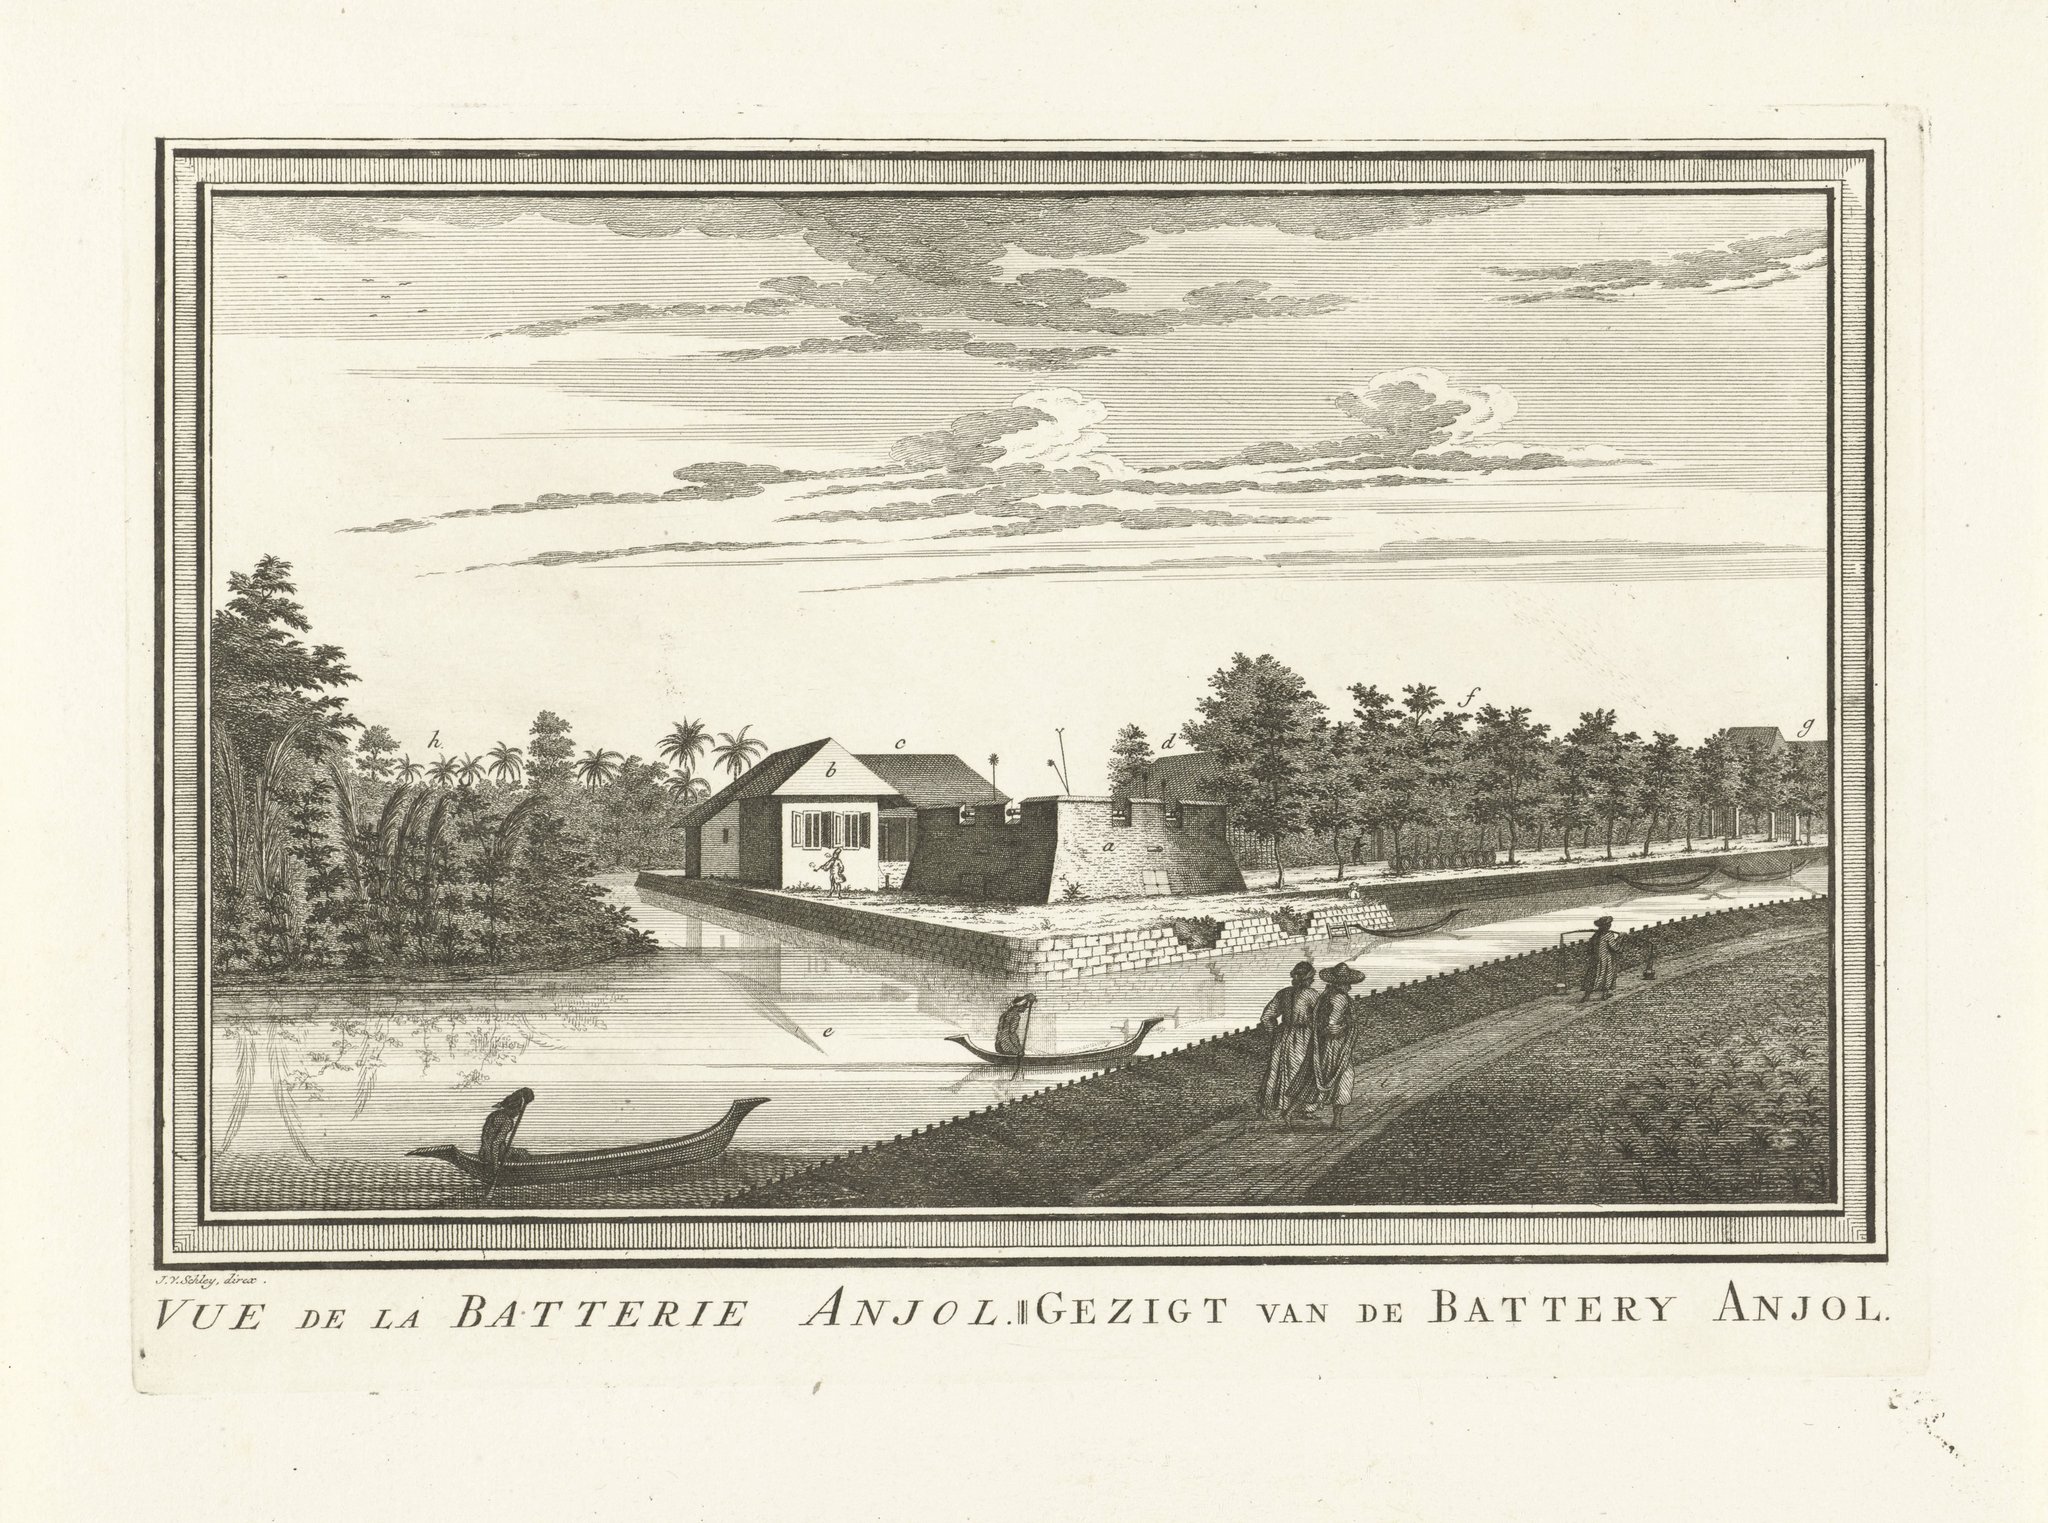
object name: print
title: Gezicht op de vesting Anjol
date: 1747-1779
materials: paper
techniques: engraving, etching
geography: the hague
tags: fortress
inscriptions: collector's mark: Lugt 2228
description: Illustratie in: Bois, J.P.J. du: Histoire Générale Des Voyages, Ou Nouvelle Collection De Toutes Les Relations De Voyages Par Mer Et Par Terre, deel XVII, Den Haag: Pierre de Hondt, 1747- 1779, na p. 264.